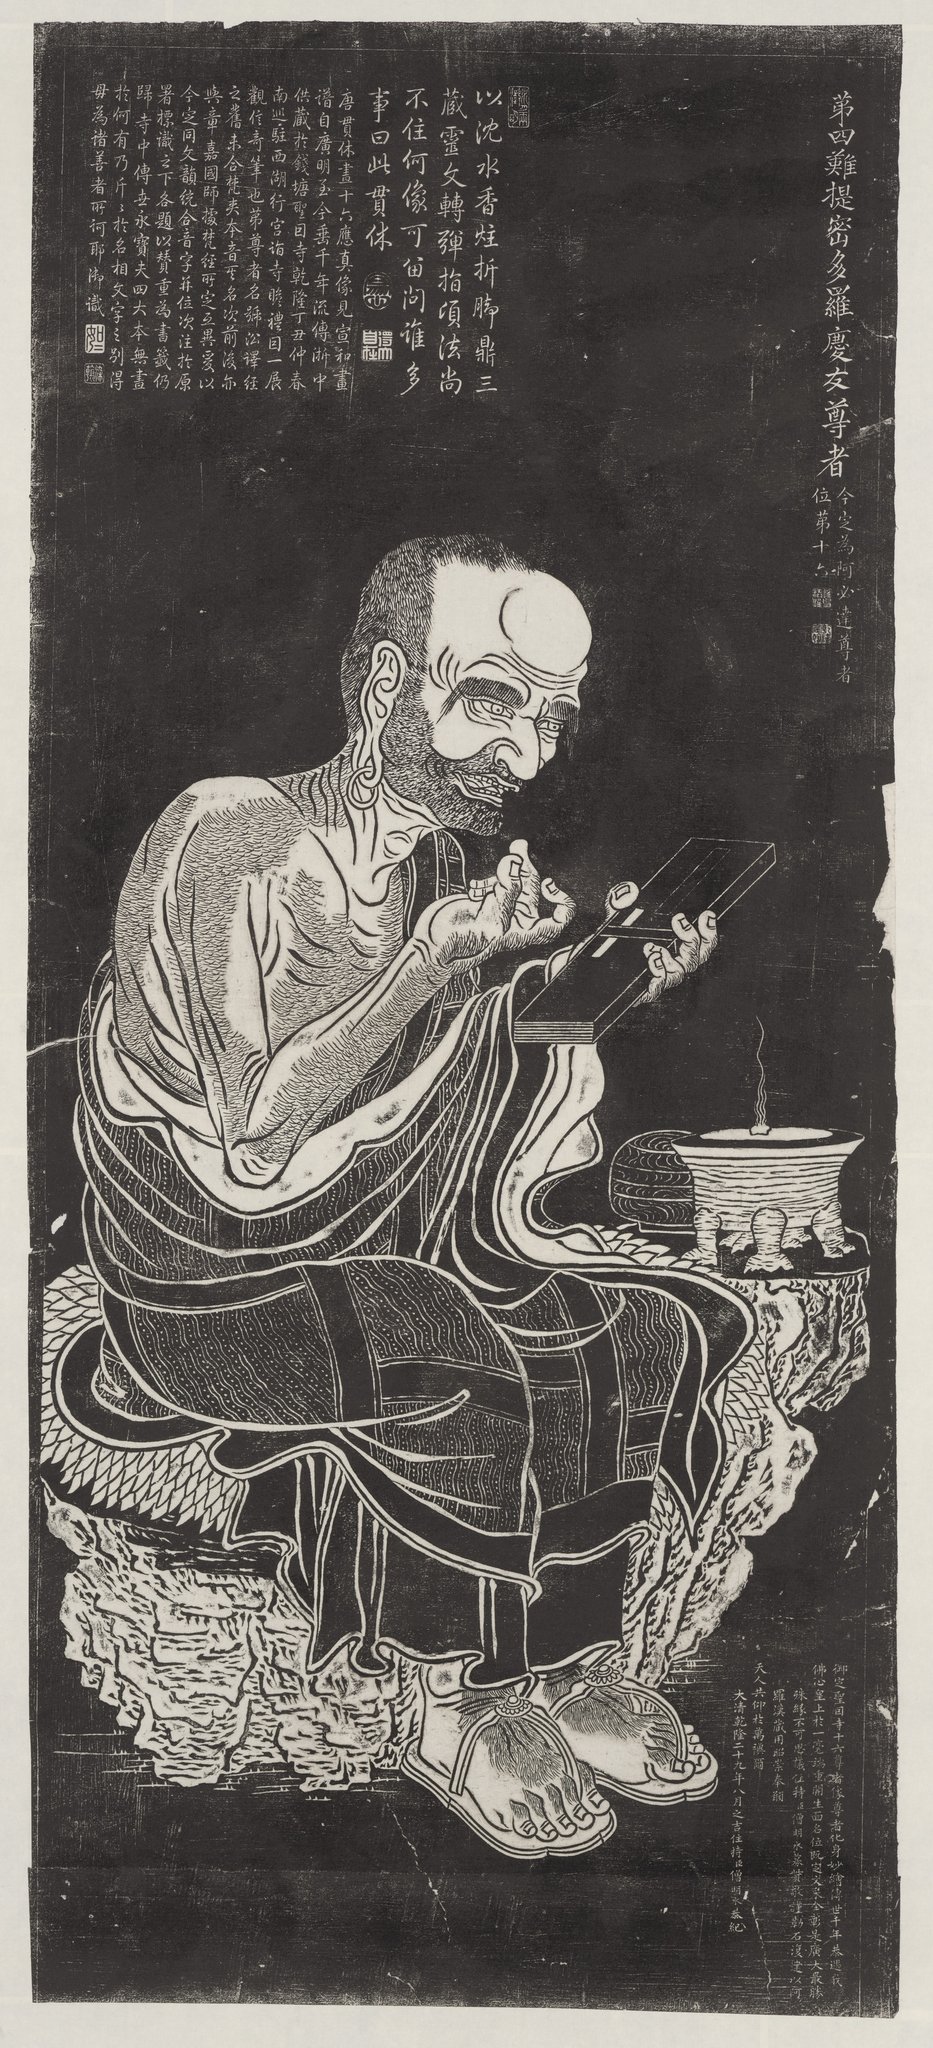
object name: rubbing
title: Luohan, after a set attributed to Guanxiu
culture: chinese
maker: unidentified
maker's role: artist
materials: paper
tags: men